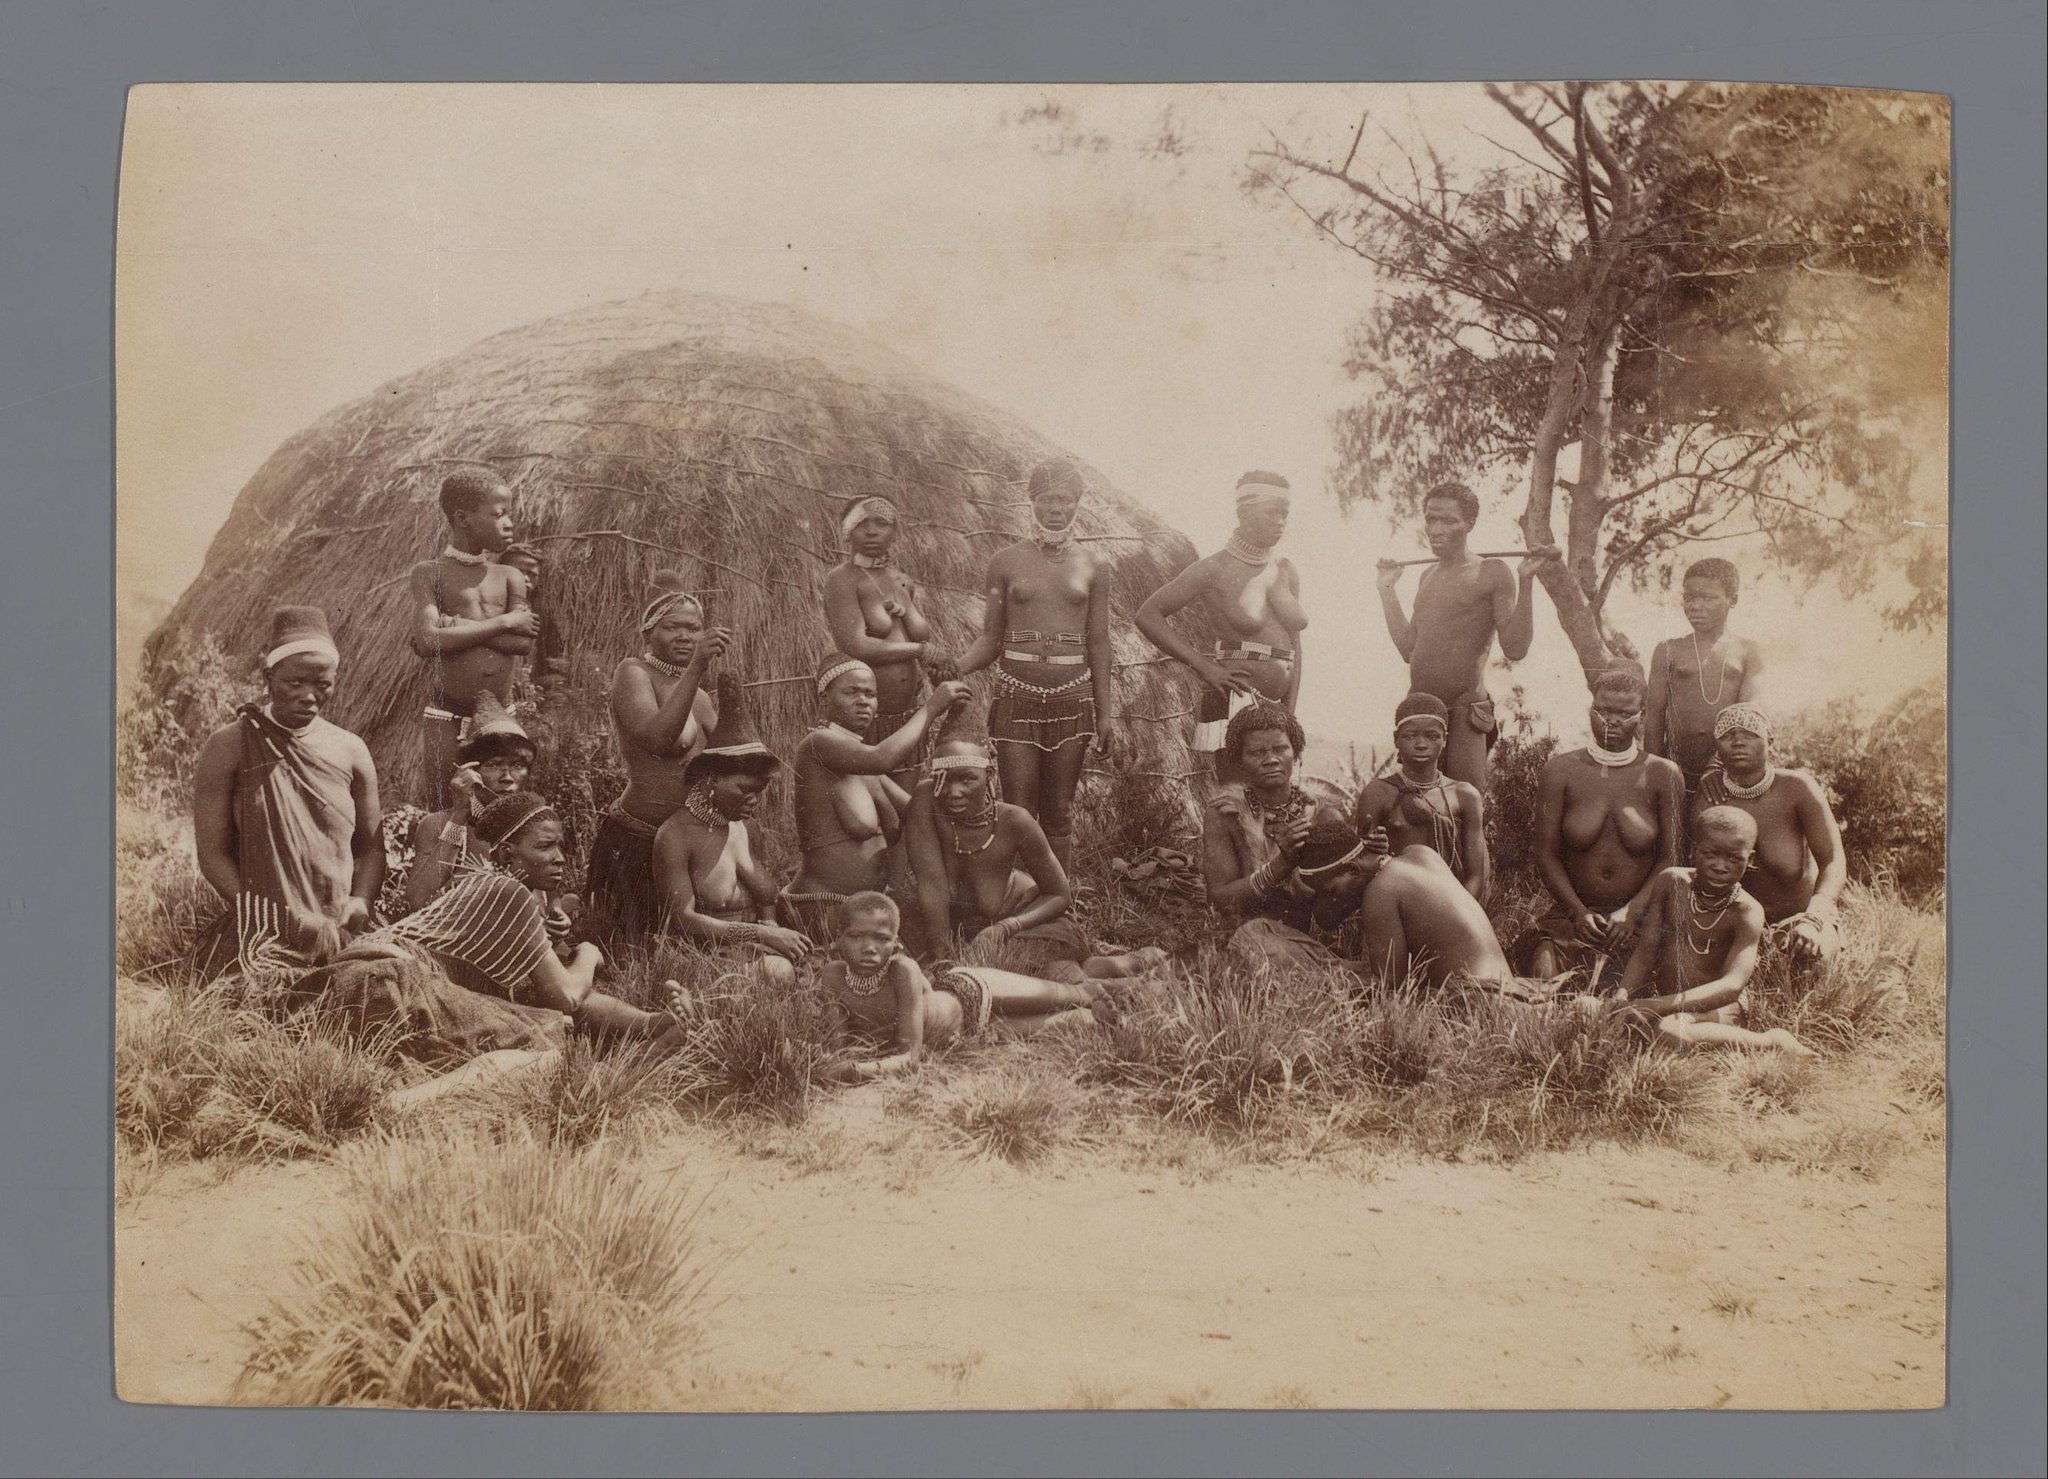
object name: photograph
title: Dorpsbewoners voor een hut, Afrika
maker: Anonymous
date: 1880-1900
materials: paper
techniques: albumen print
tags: afrika